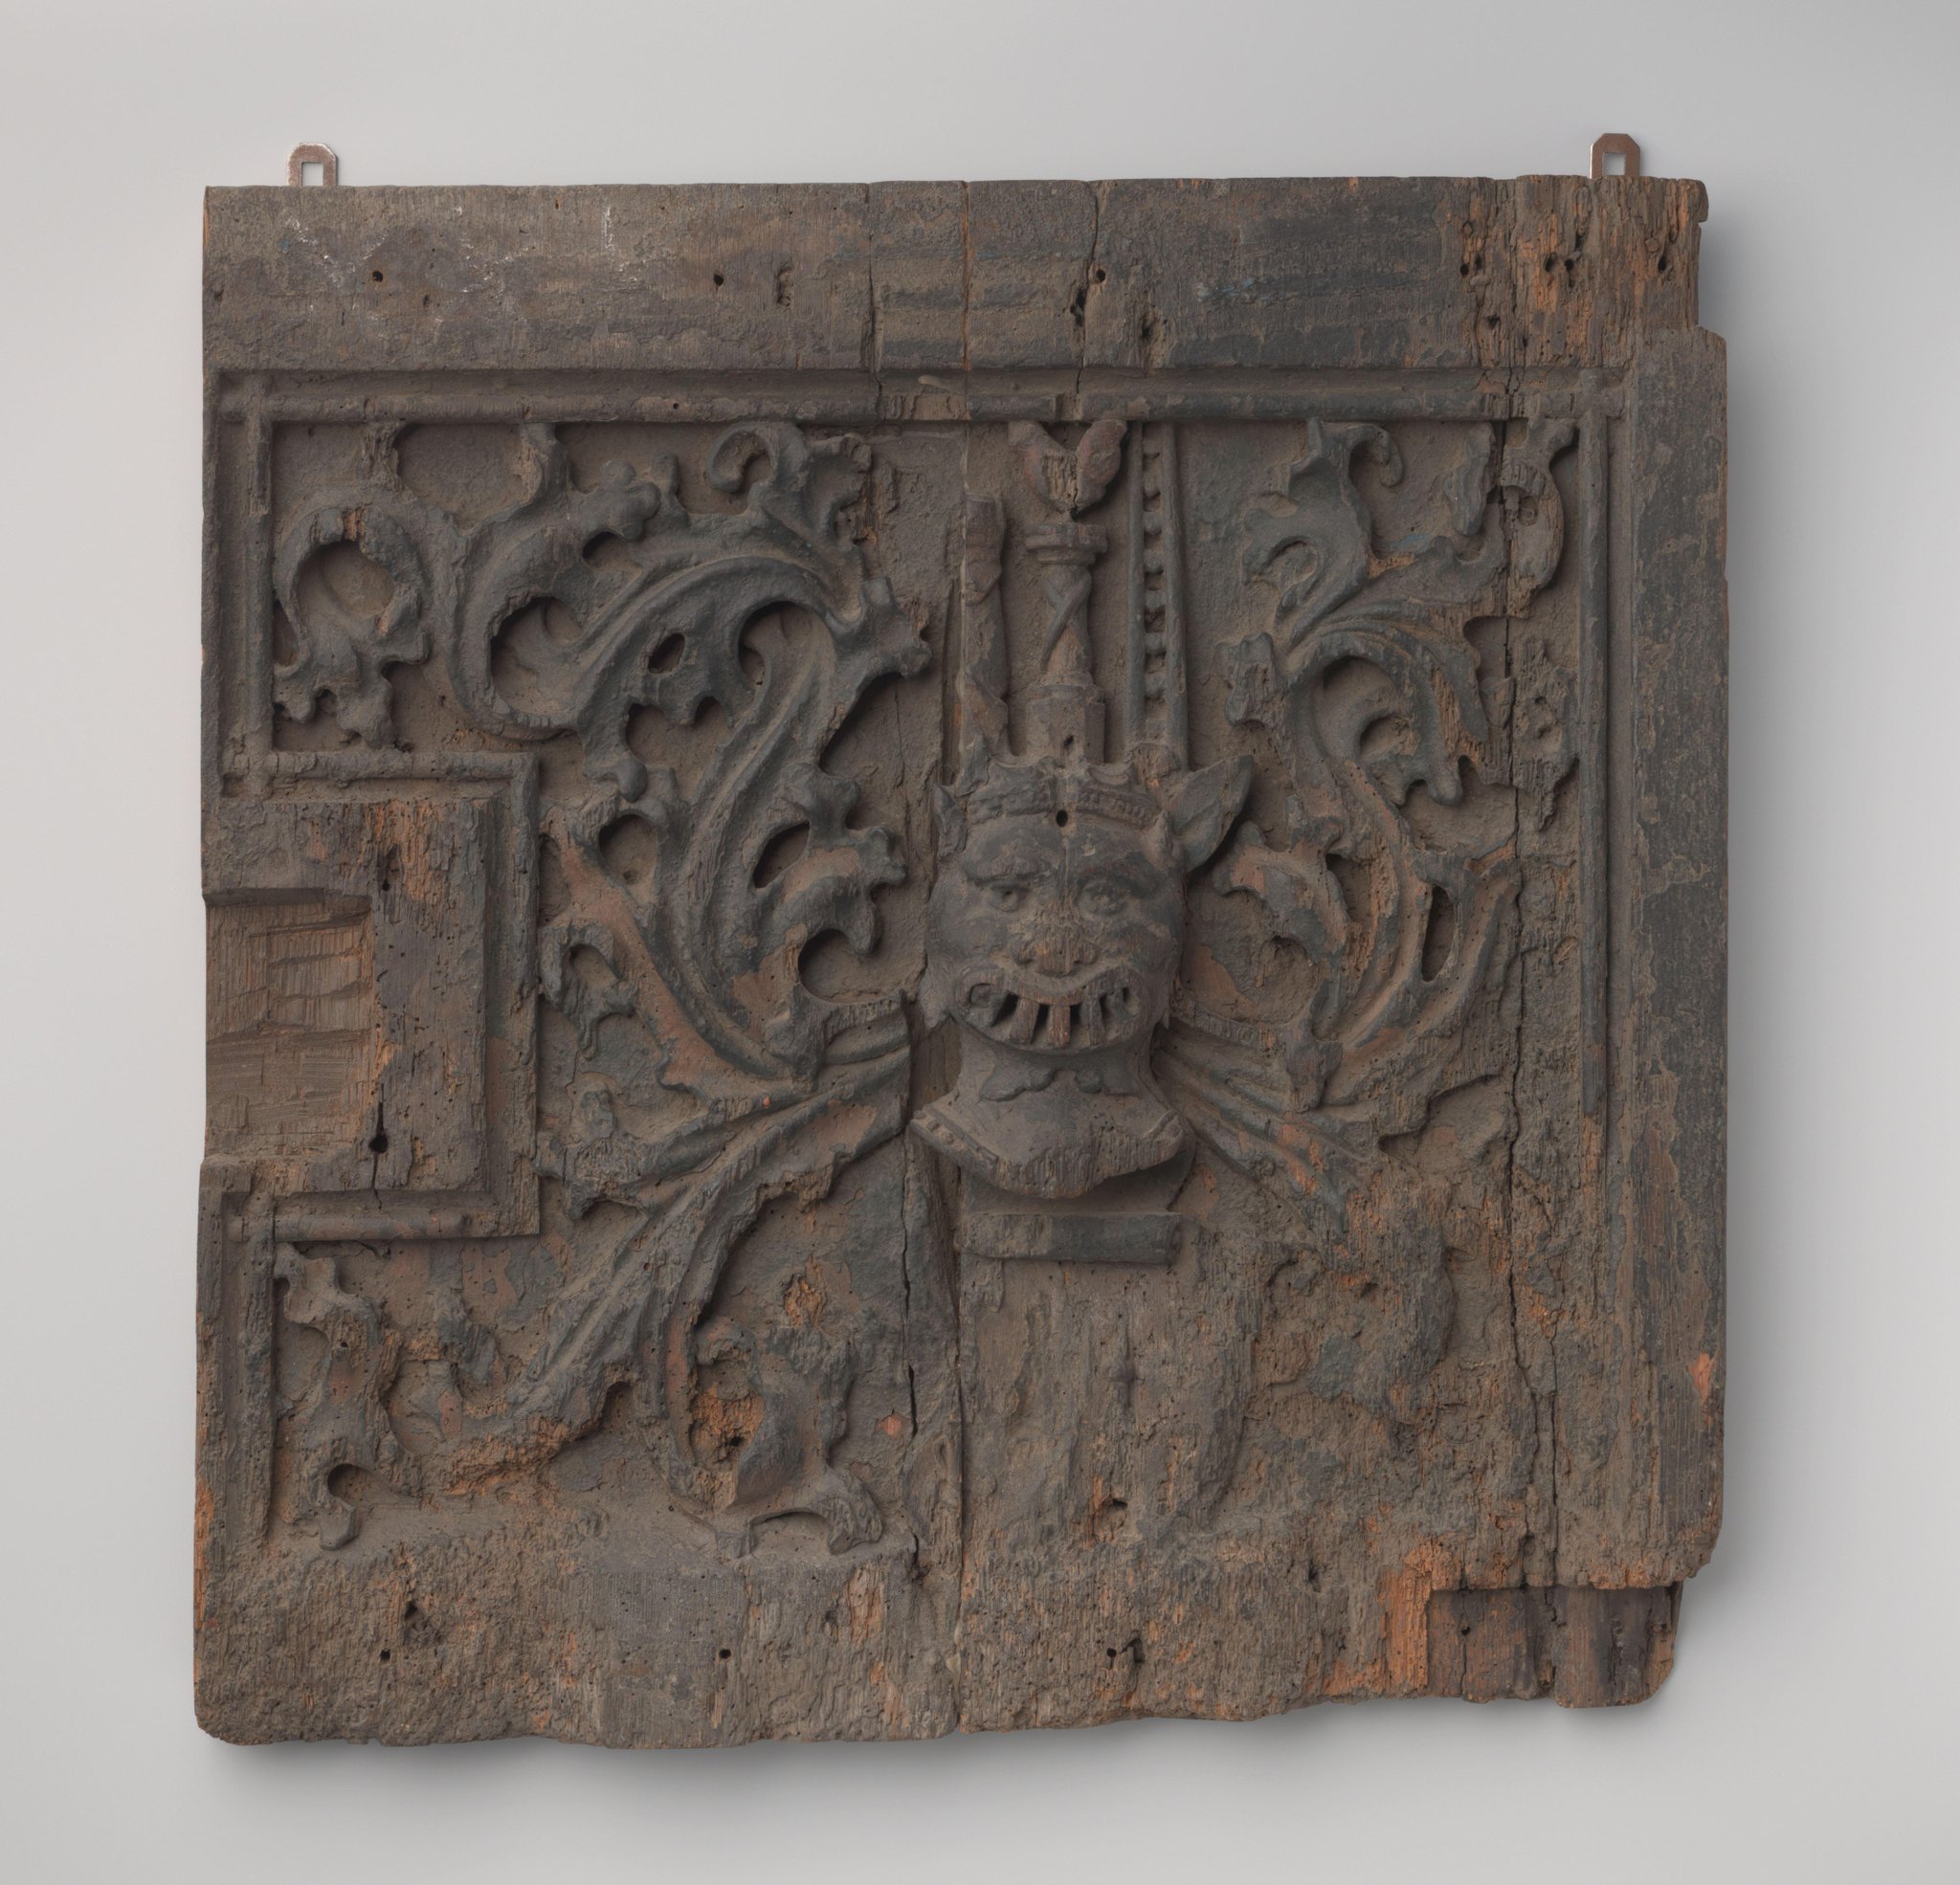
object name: door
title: Deur van een kast met diep snijwerk met wapen waarvan het helmteken bestaat uit geselpaal met haan en ladder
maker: Anonymous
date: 1500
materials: wood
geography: northern netherlands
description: Door from a cabinet. Oak. Netherlands or Germany, c. 1500. On loan from the Royal Antiquarian Society.